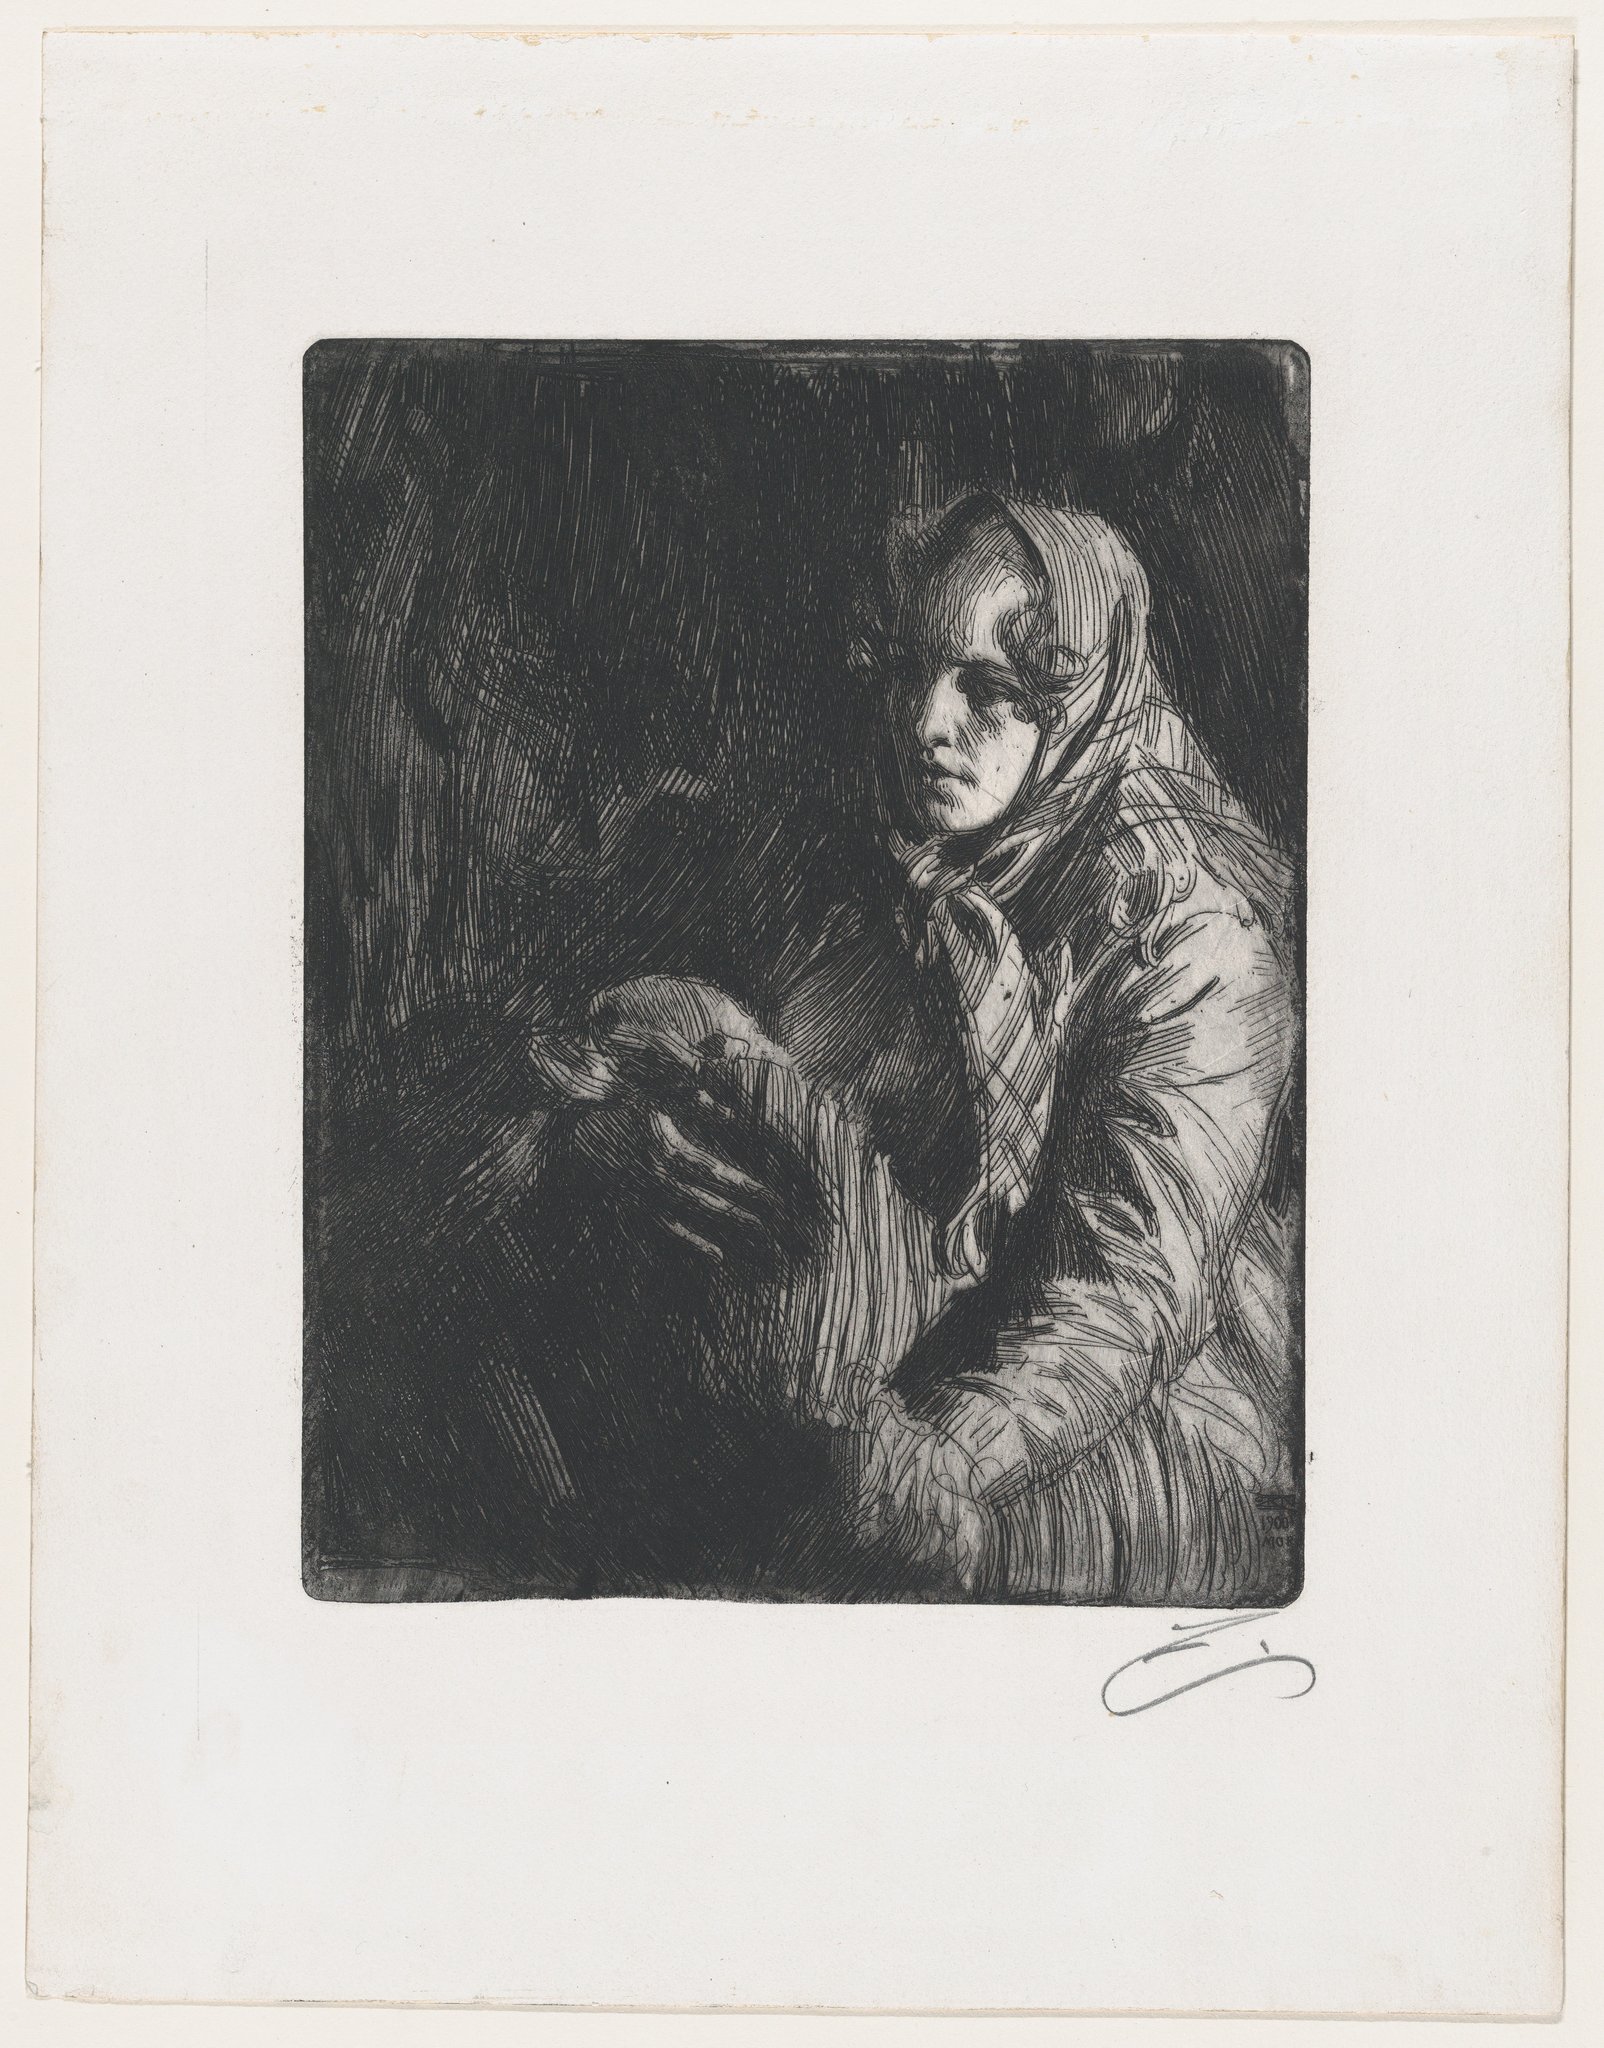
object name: print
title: Madonna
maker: anders zorn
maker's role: artist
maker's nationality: swedish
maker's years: 1860-1920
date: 1900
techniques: etching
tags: madonna